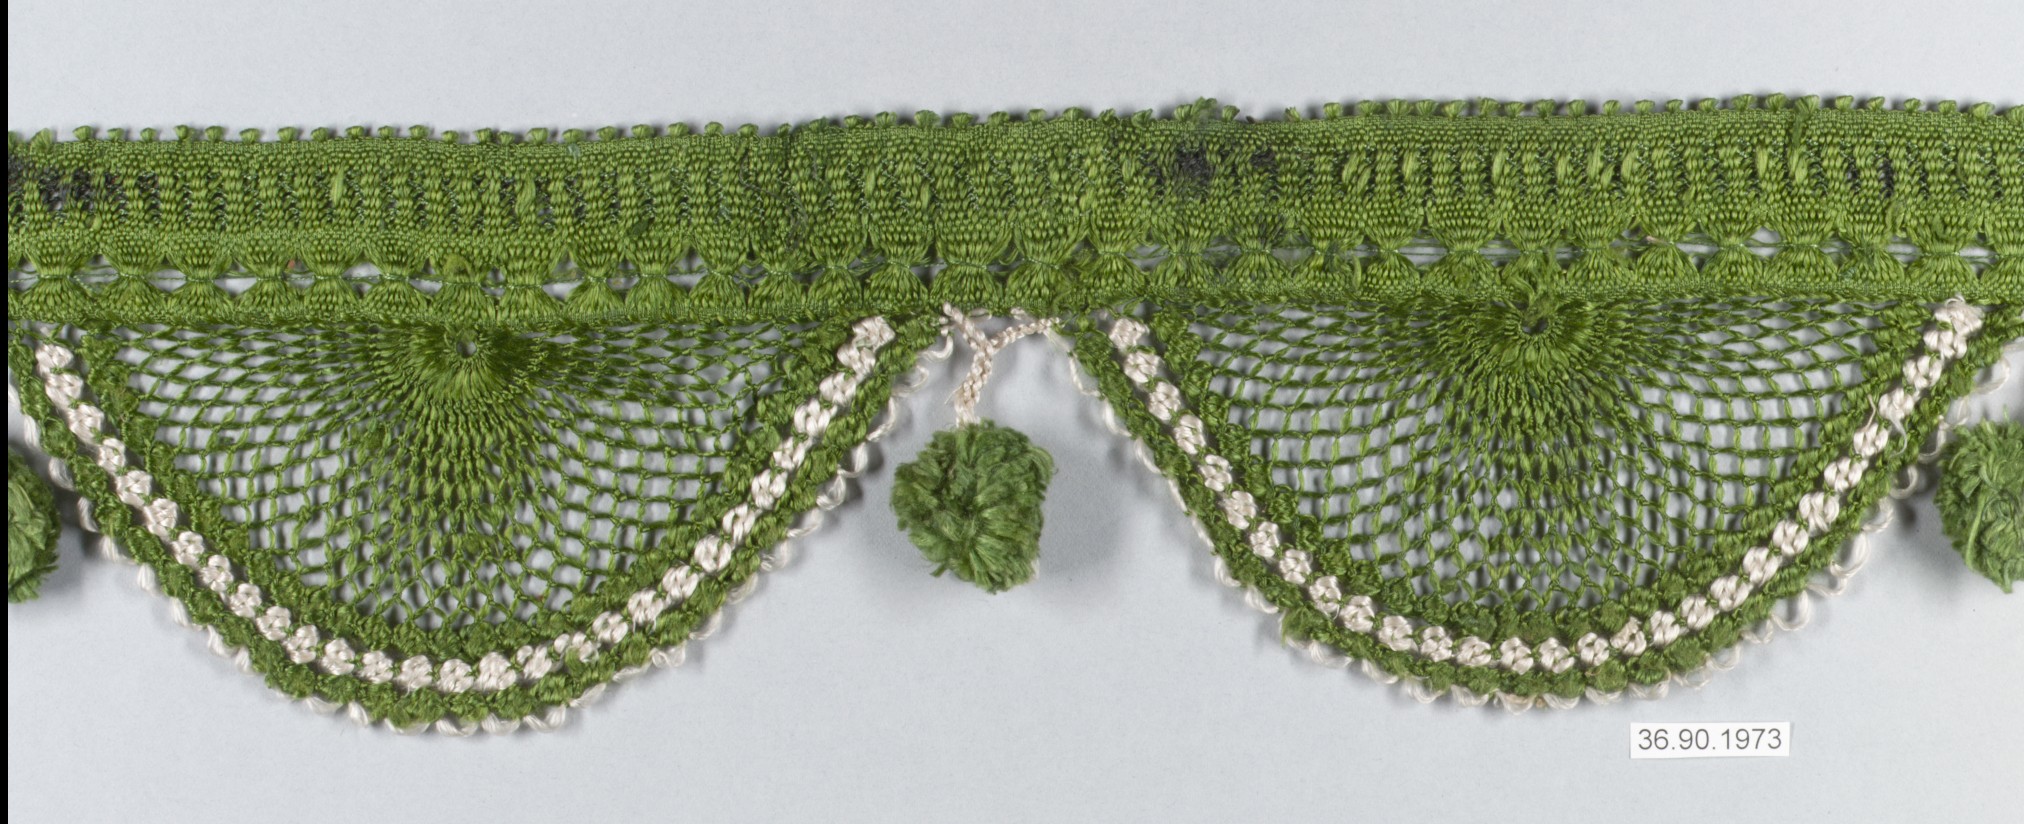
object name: fringe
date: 1801-1900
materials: silk